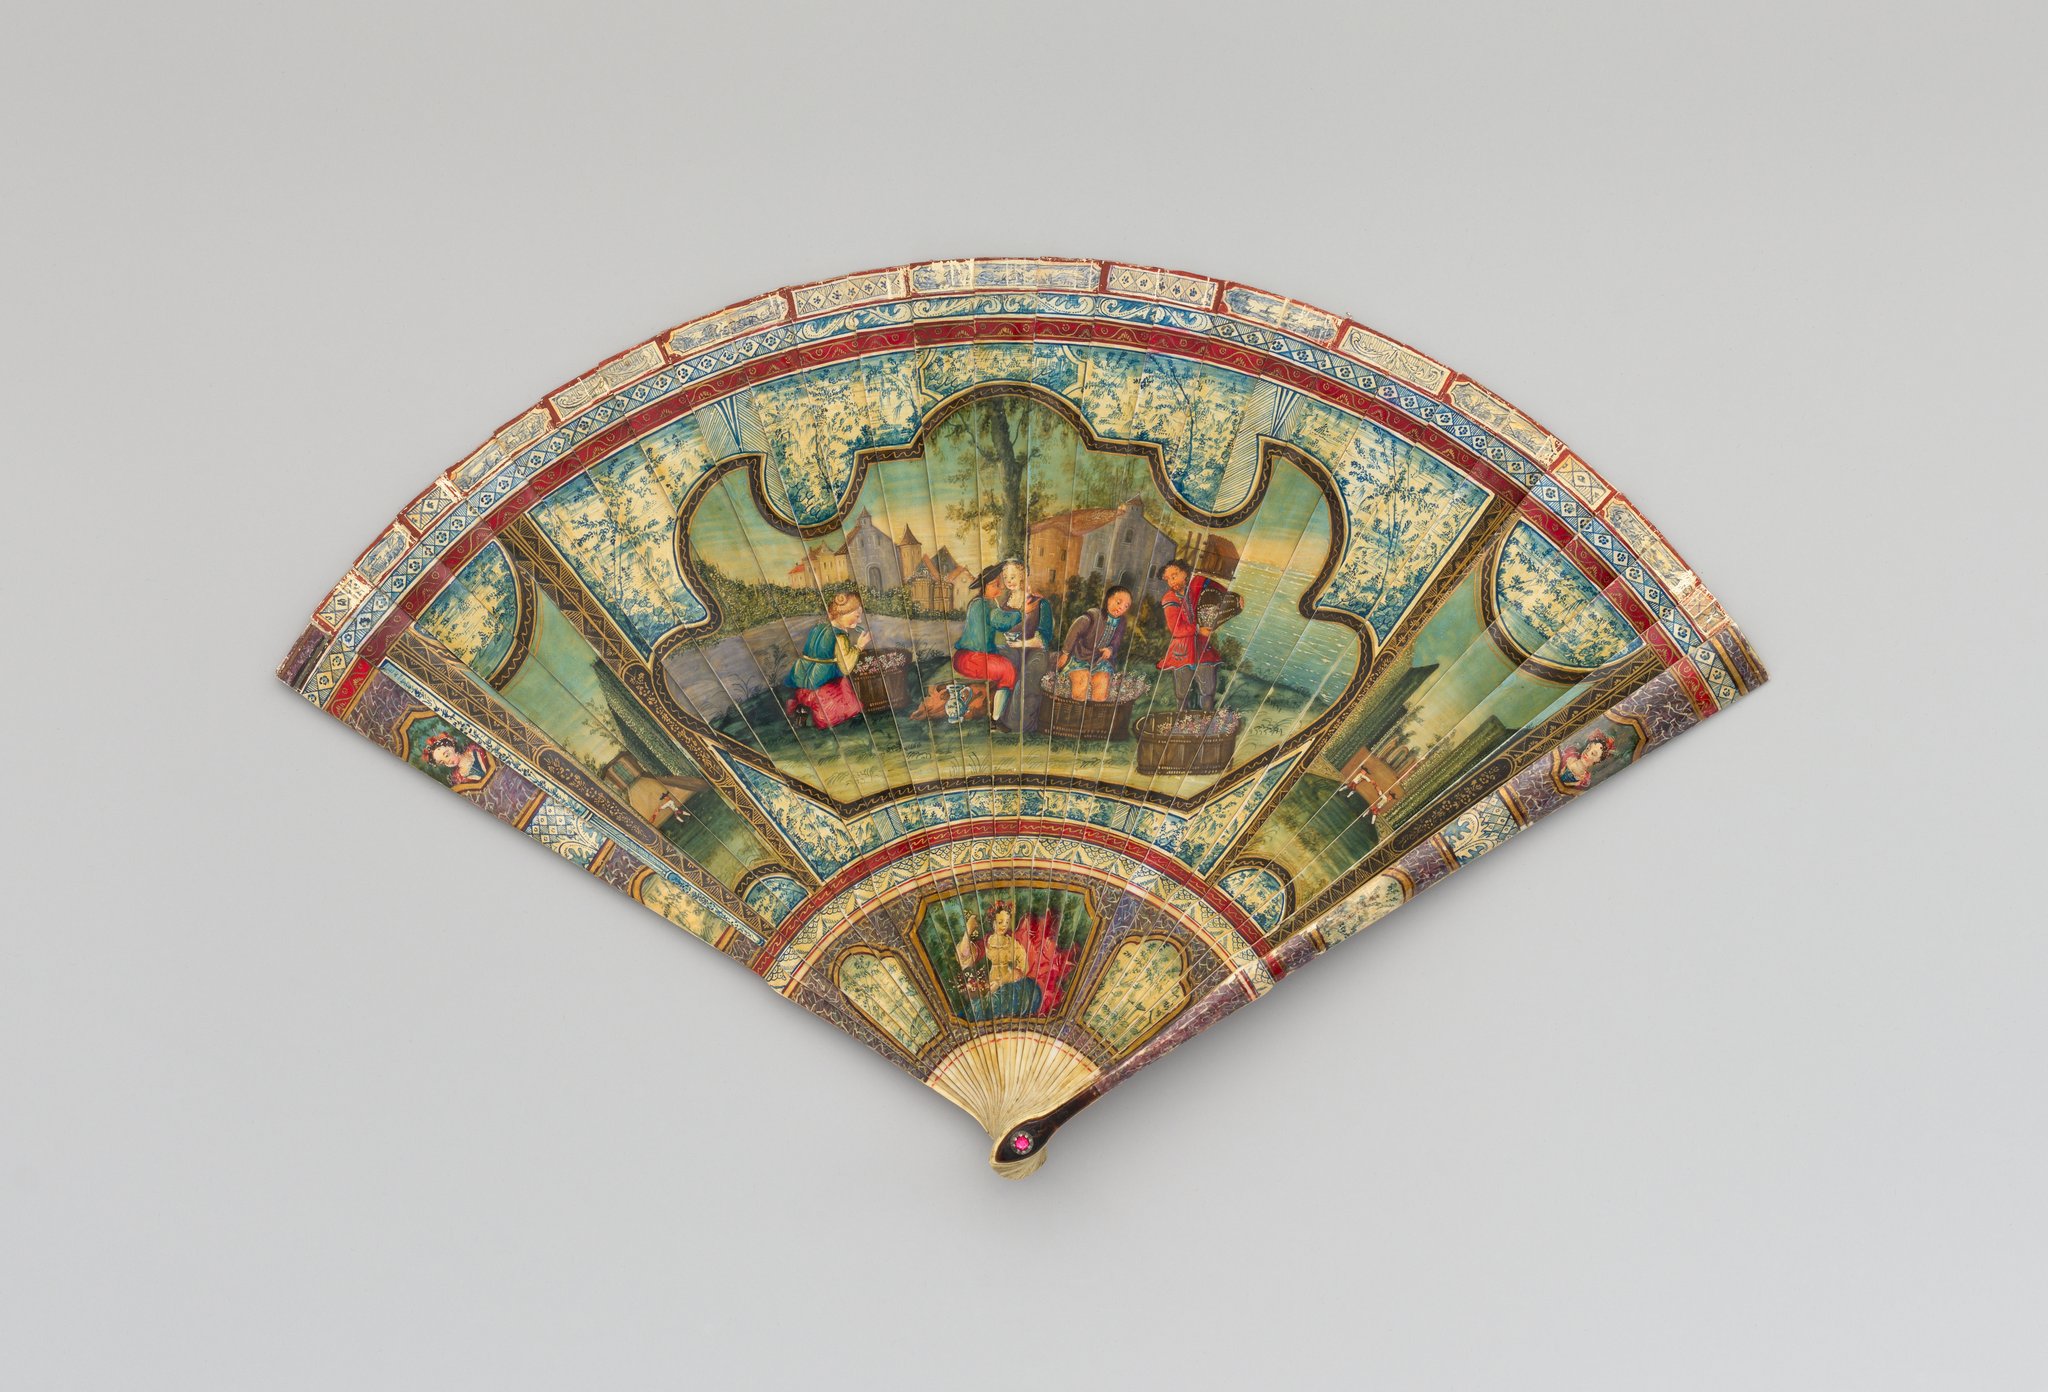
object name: fan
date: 1701-1800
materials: ivory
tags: men,women,boats